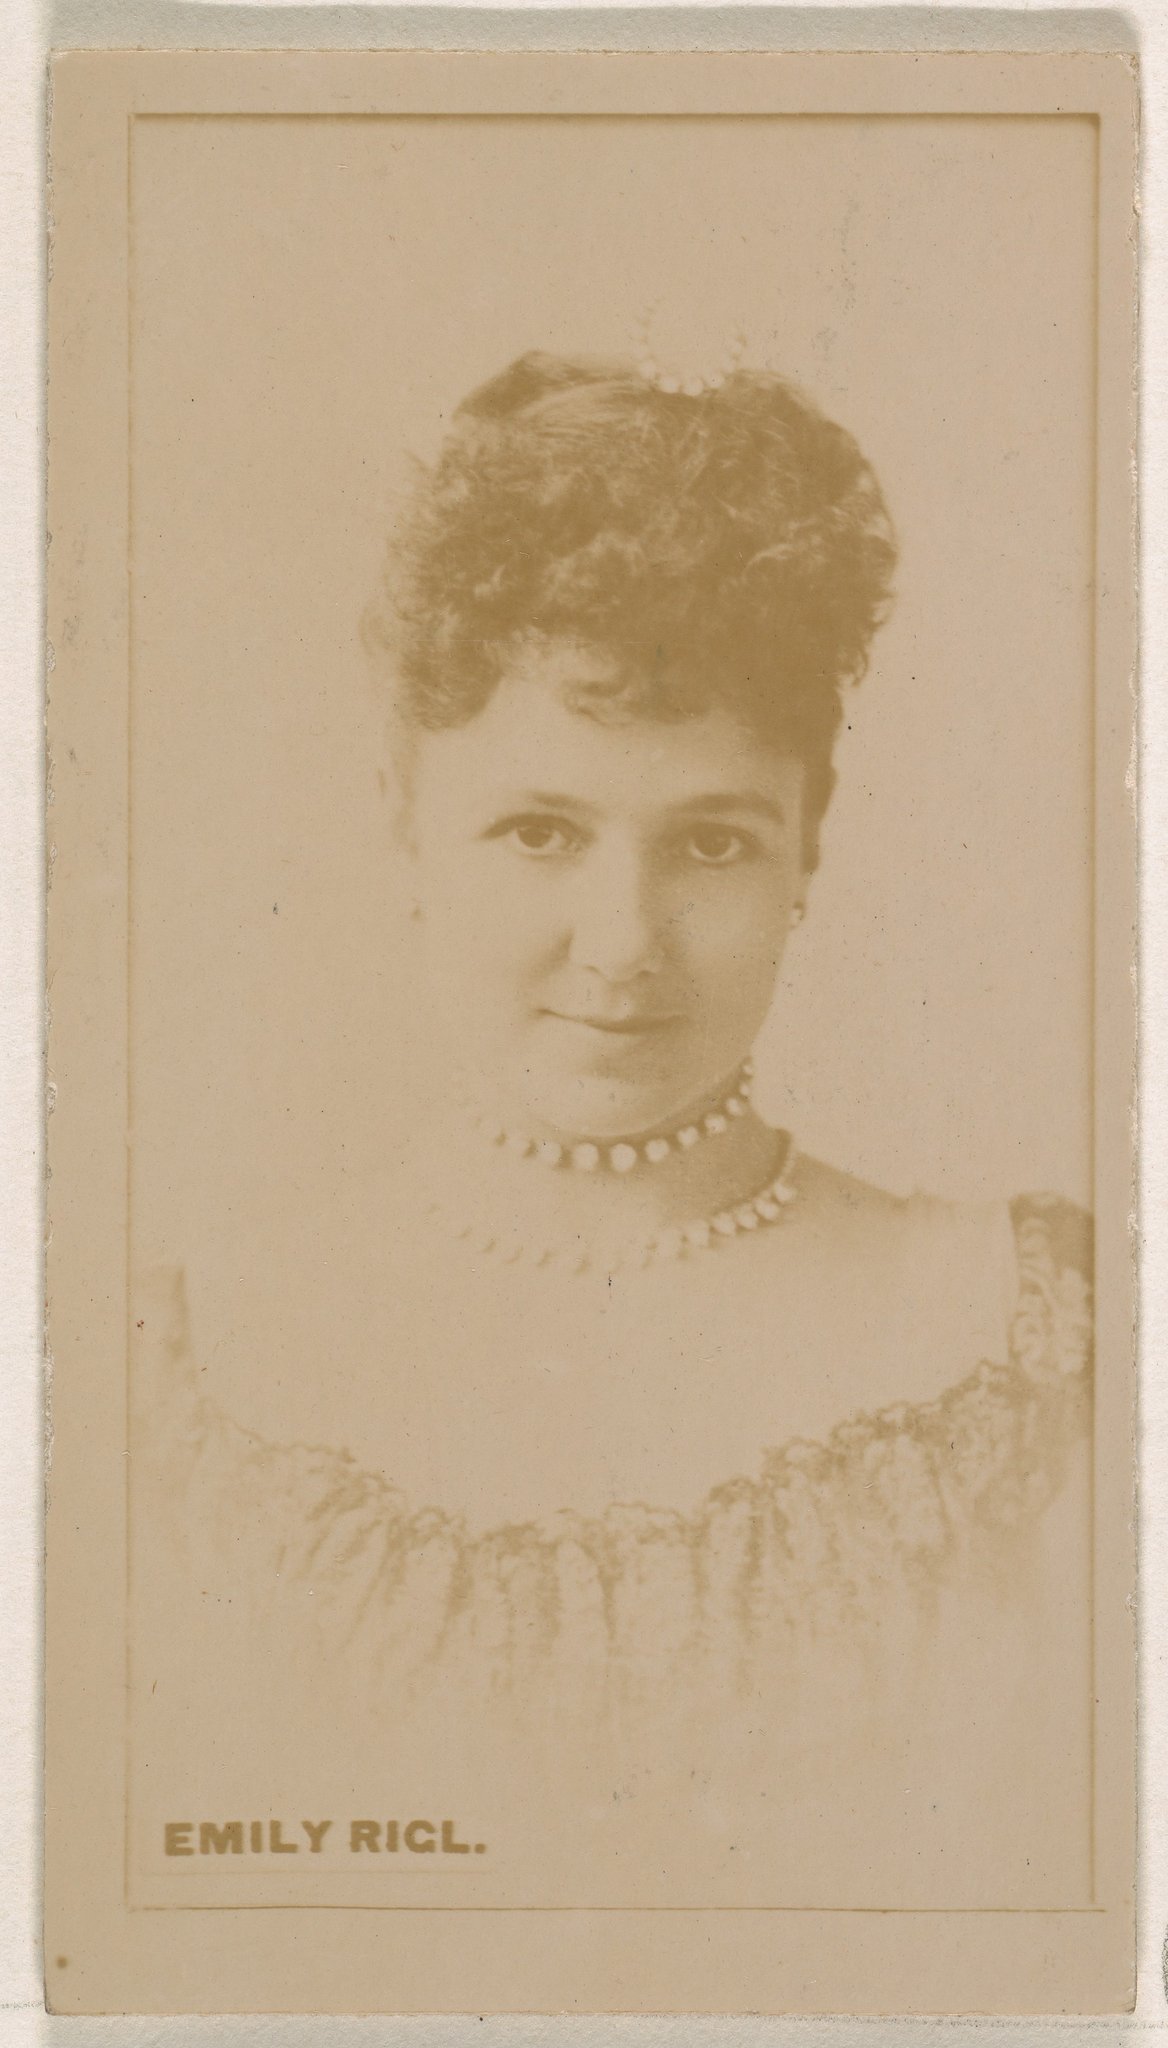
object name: photograph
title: Emily Rigl, from the Actresses series (N245) issued by Kinney Brothers to promote Sweet Caporal Cigarettes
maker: kinney brothers tobacco company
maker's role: publisher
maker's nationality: american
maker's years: 1869-2011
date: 1890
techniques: albumen silver print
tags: portraits,women,actresses